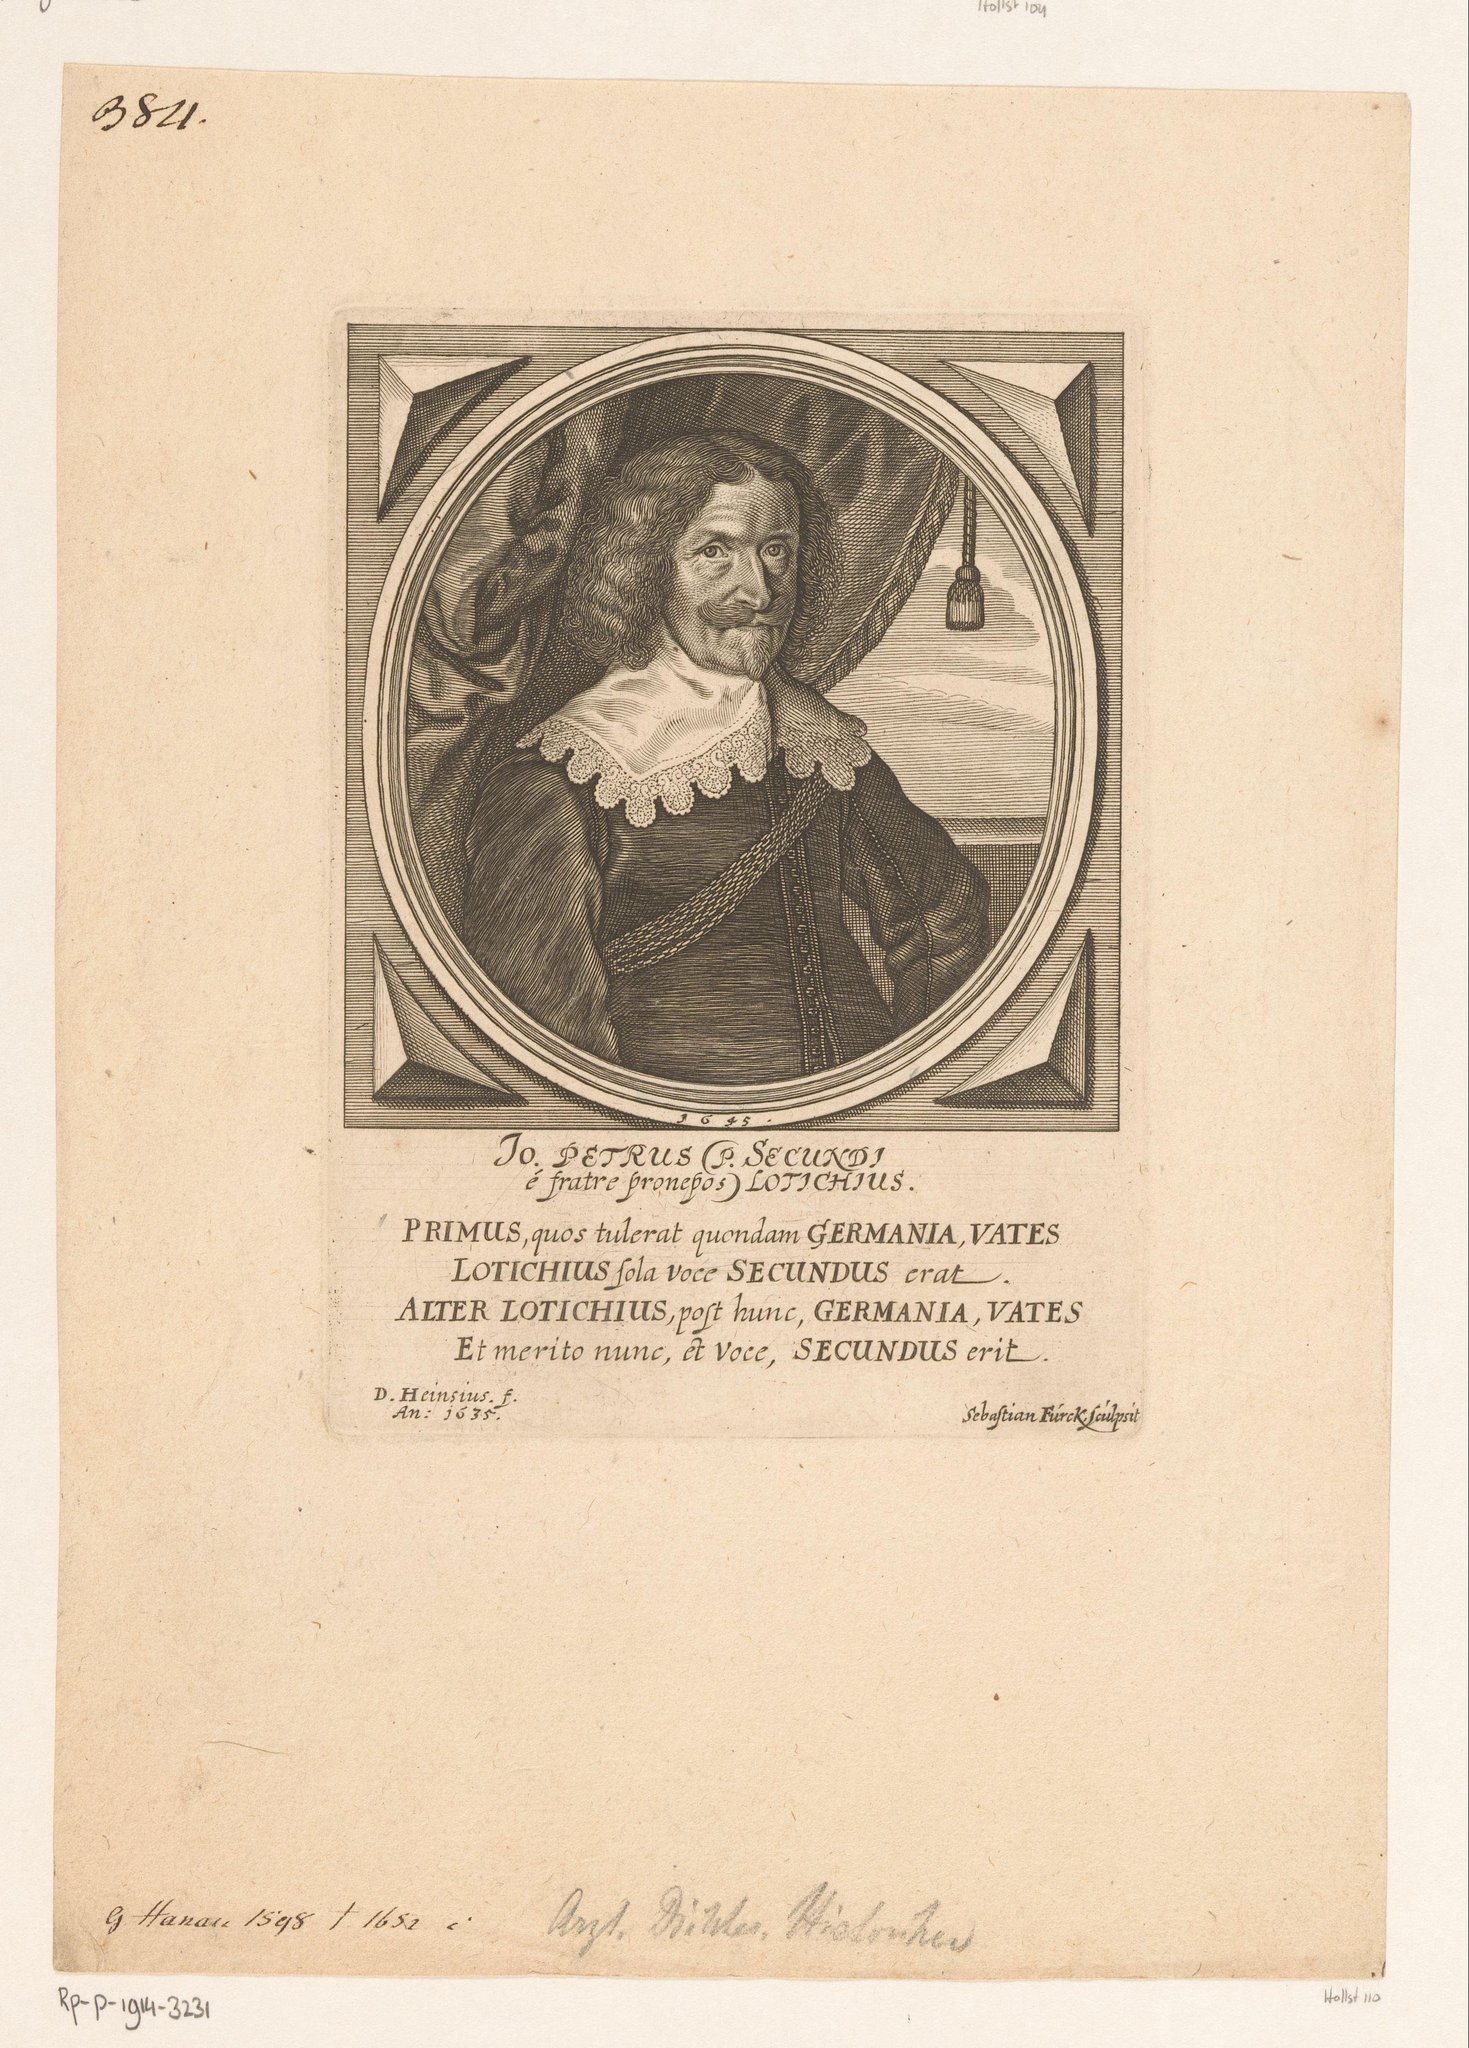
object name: print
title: Portret van Johannes Peter Lotichius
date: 1635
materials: paper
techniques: engraving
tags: historical persons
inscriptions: collector's mark: Lugt 2228